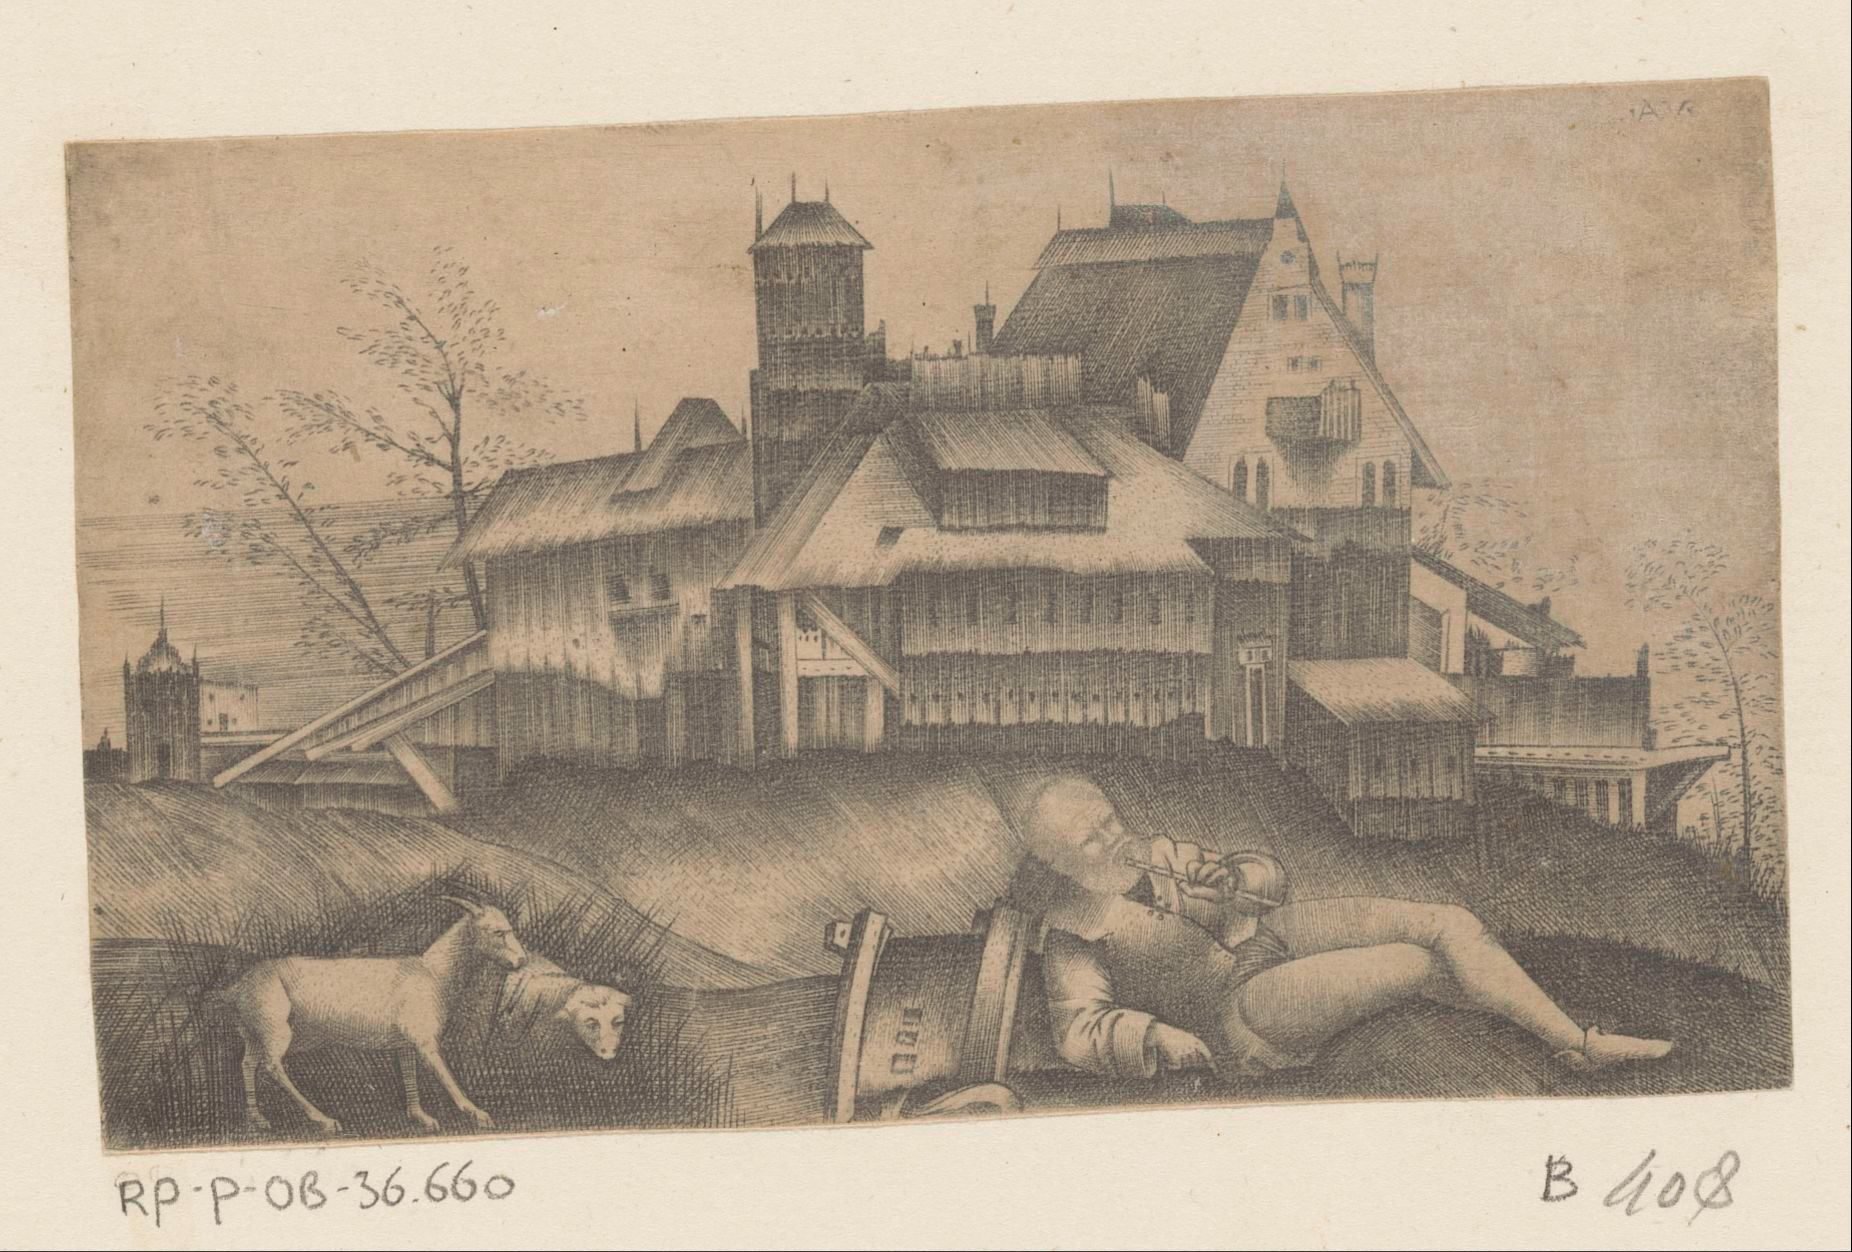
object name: print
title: Oude herder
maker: agostino veneziano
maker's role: draughtsman, painter, print maker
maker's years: 1490-1536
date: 1500-1536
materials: paper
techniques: engraving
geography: italy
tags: city-view, and landscape with man-made constructions, herding, herdsman, herdswoman, shepherd, shepherdess, cowherd, etc., sheep, goat, flute, aulos, tibia - cc - out of doors, pastorals, arcadian scenes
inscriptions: collector's mark: Lugt 12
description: In een landschap ligt op de voorgrond een oude herder, spelend op een fluit. Links staan een schaap en een geit. Achter hen een grote groep gebouwen.